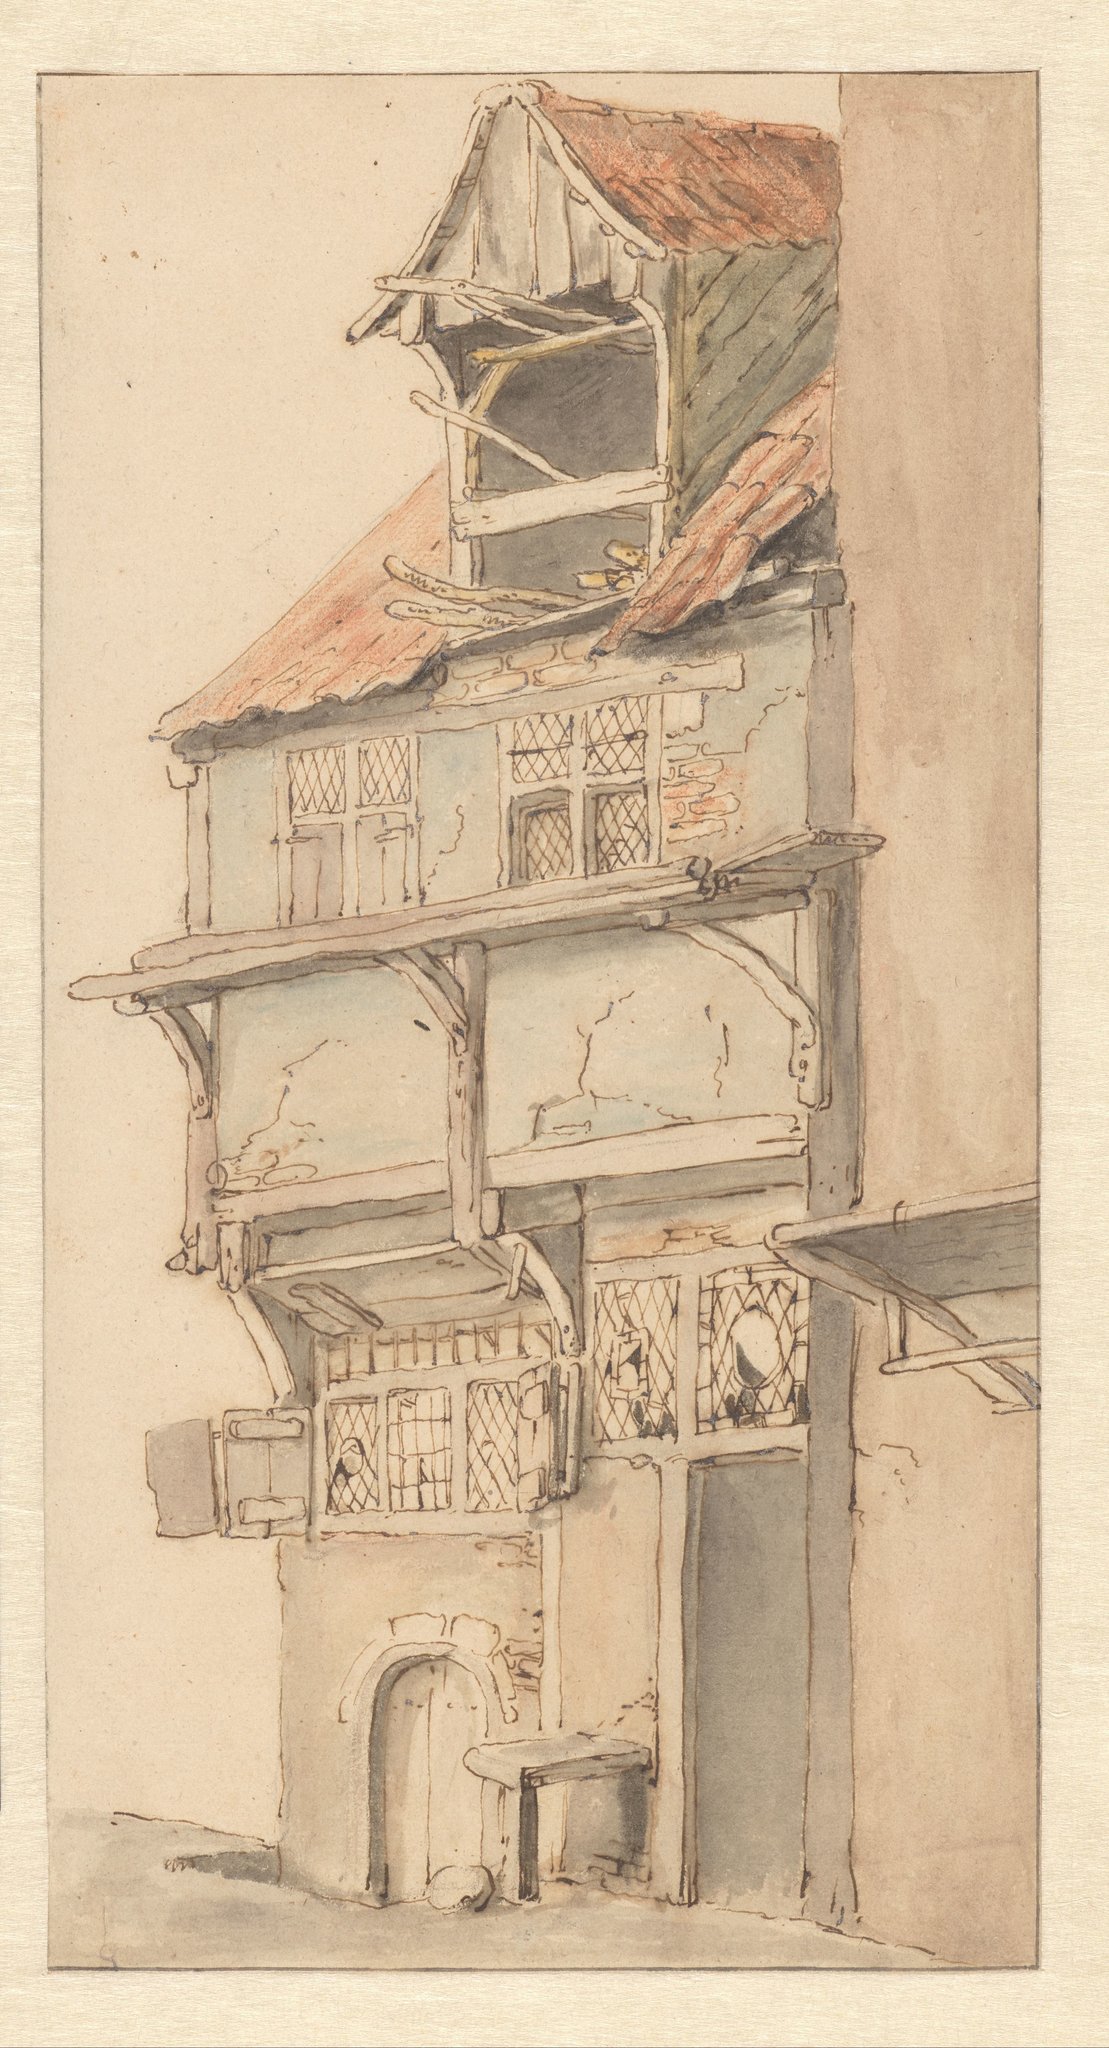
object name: drawing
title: Gevel van een hoekhuis met open dakkapel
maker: isaac van ostade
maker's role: draughtsman, painter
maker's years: 1621-1649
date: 1620-1685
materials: chalk, paper, pencil, watercolor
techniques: brush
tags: urban housing